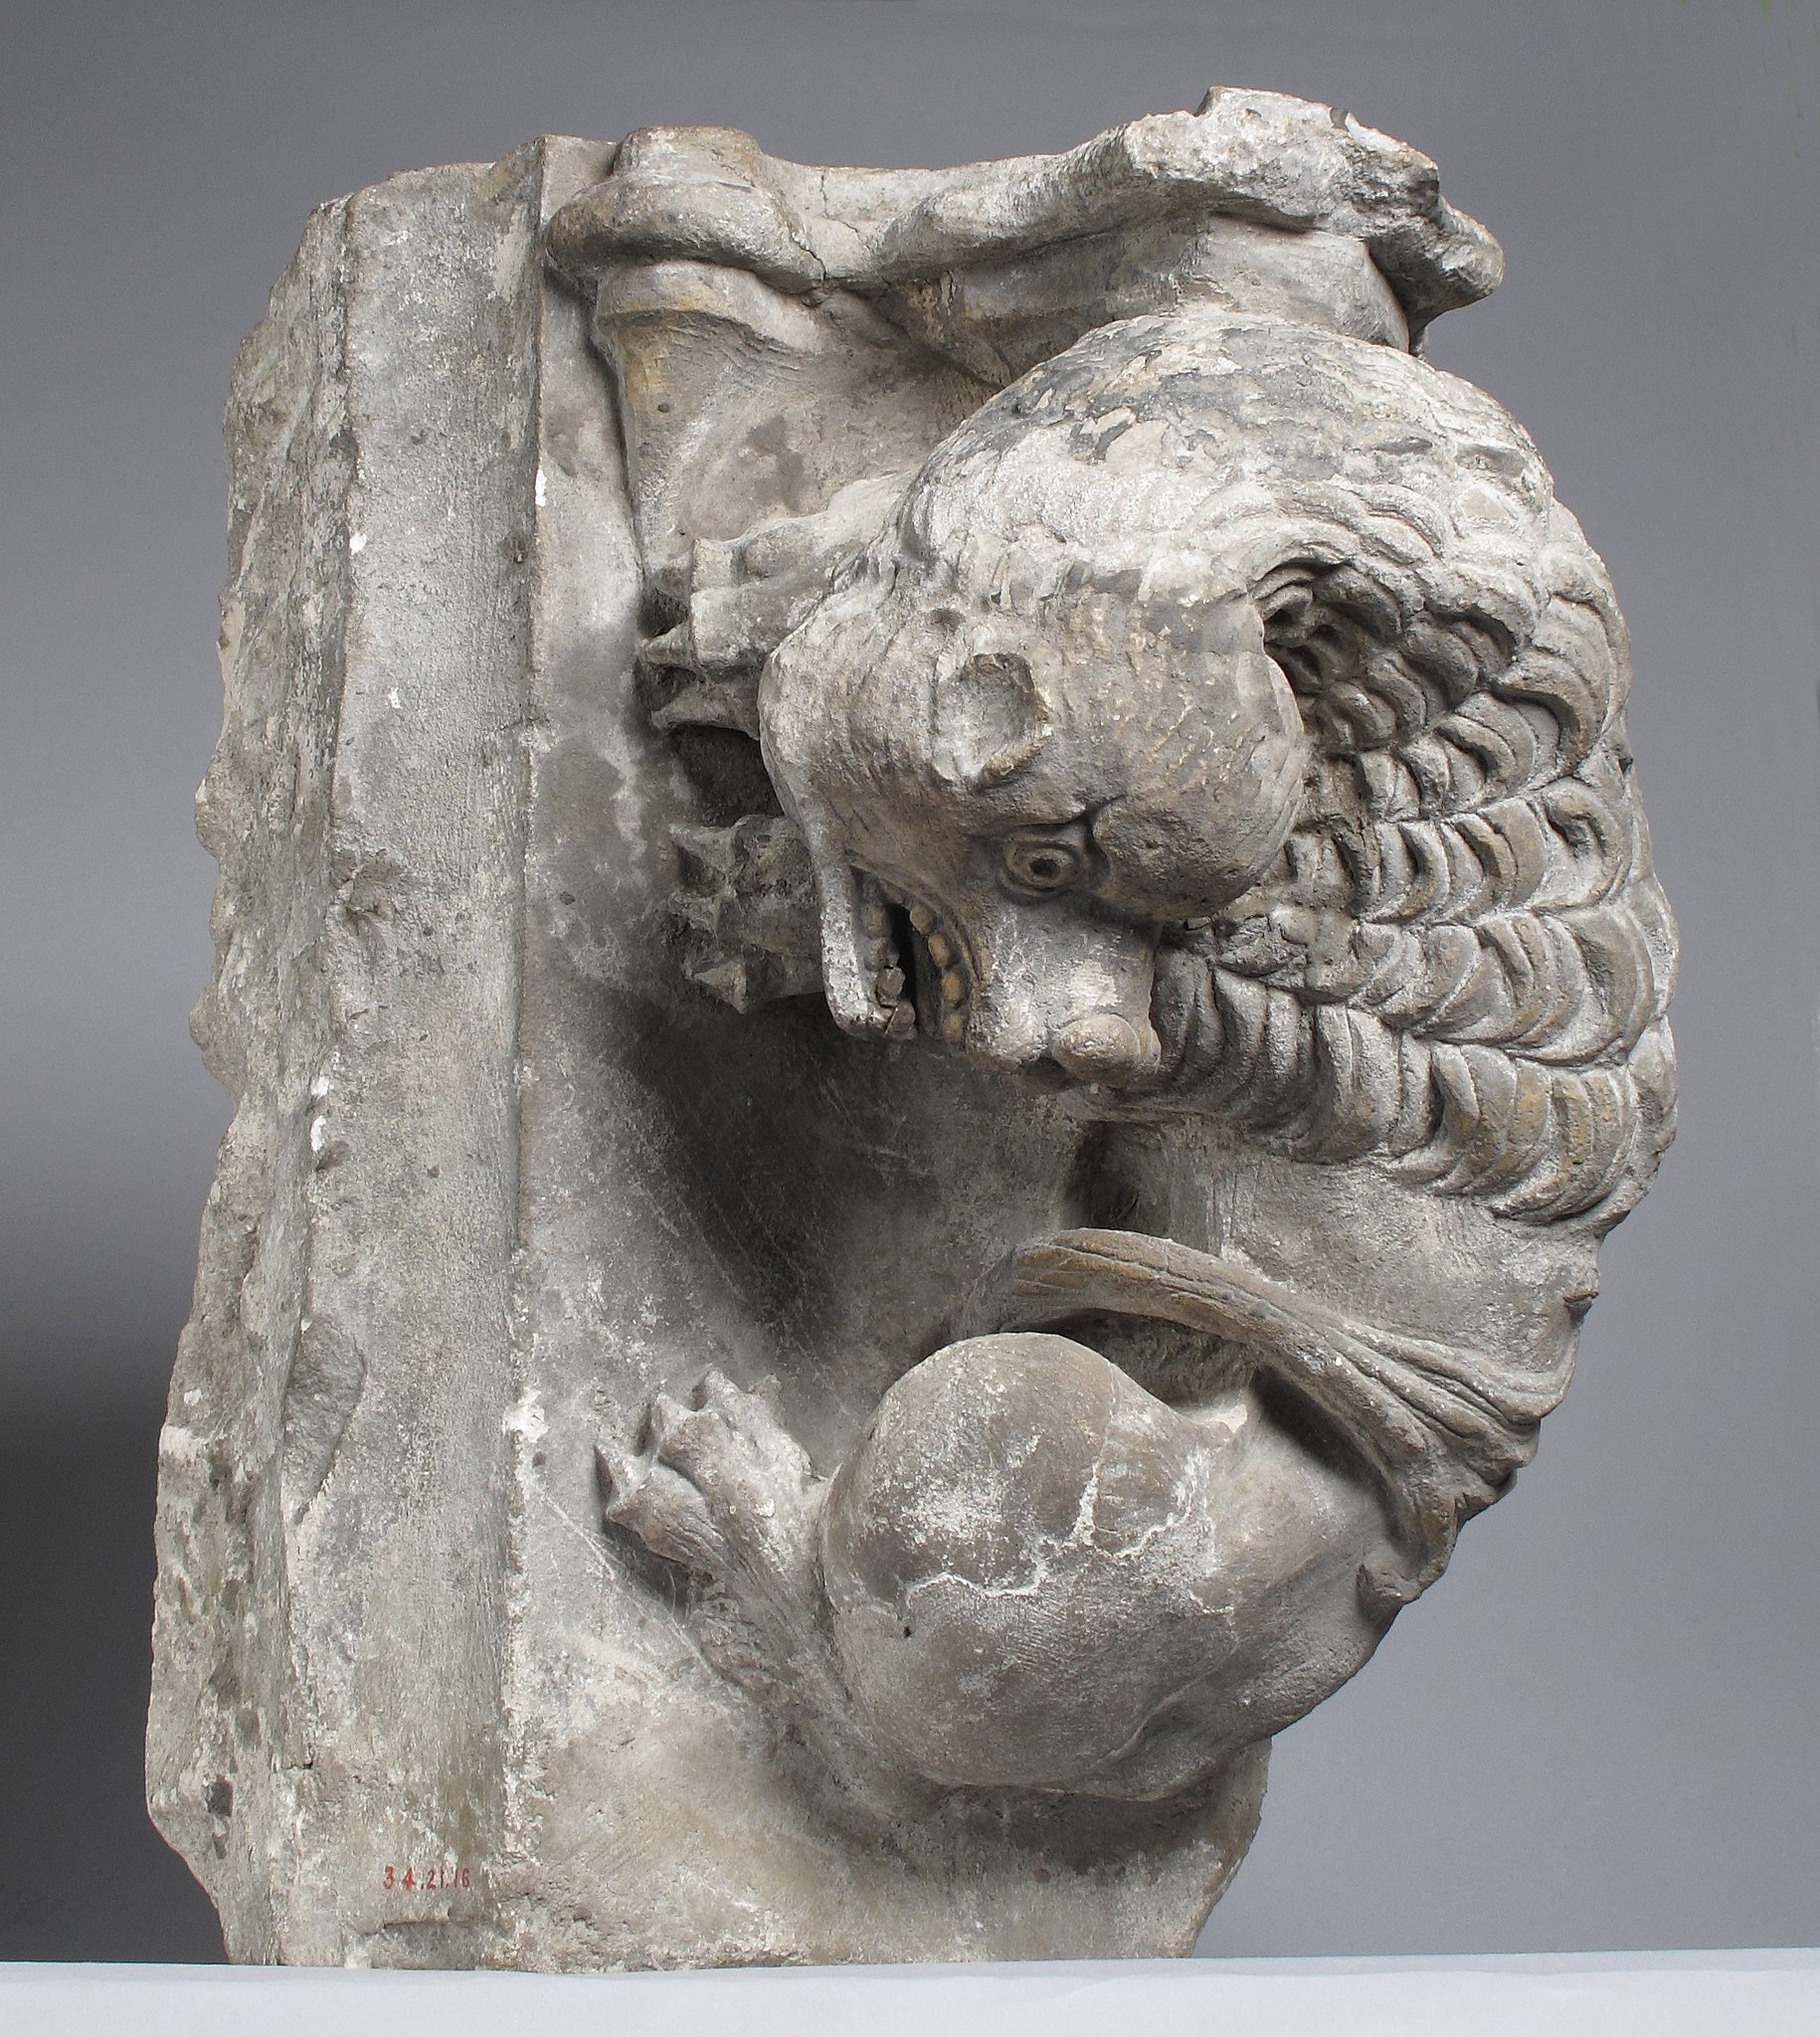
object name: corbel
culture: french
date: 1401-1500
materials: limestone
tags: animals